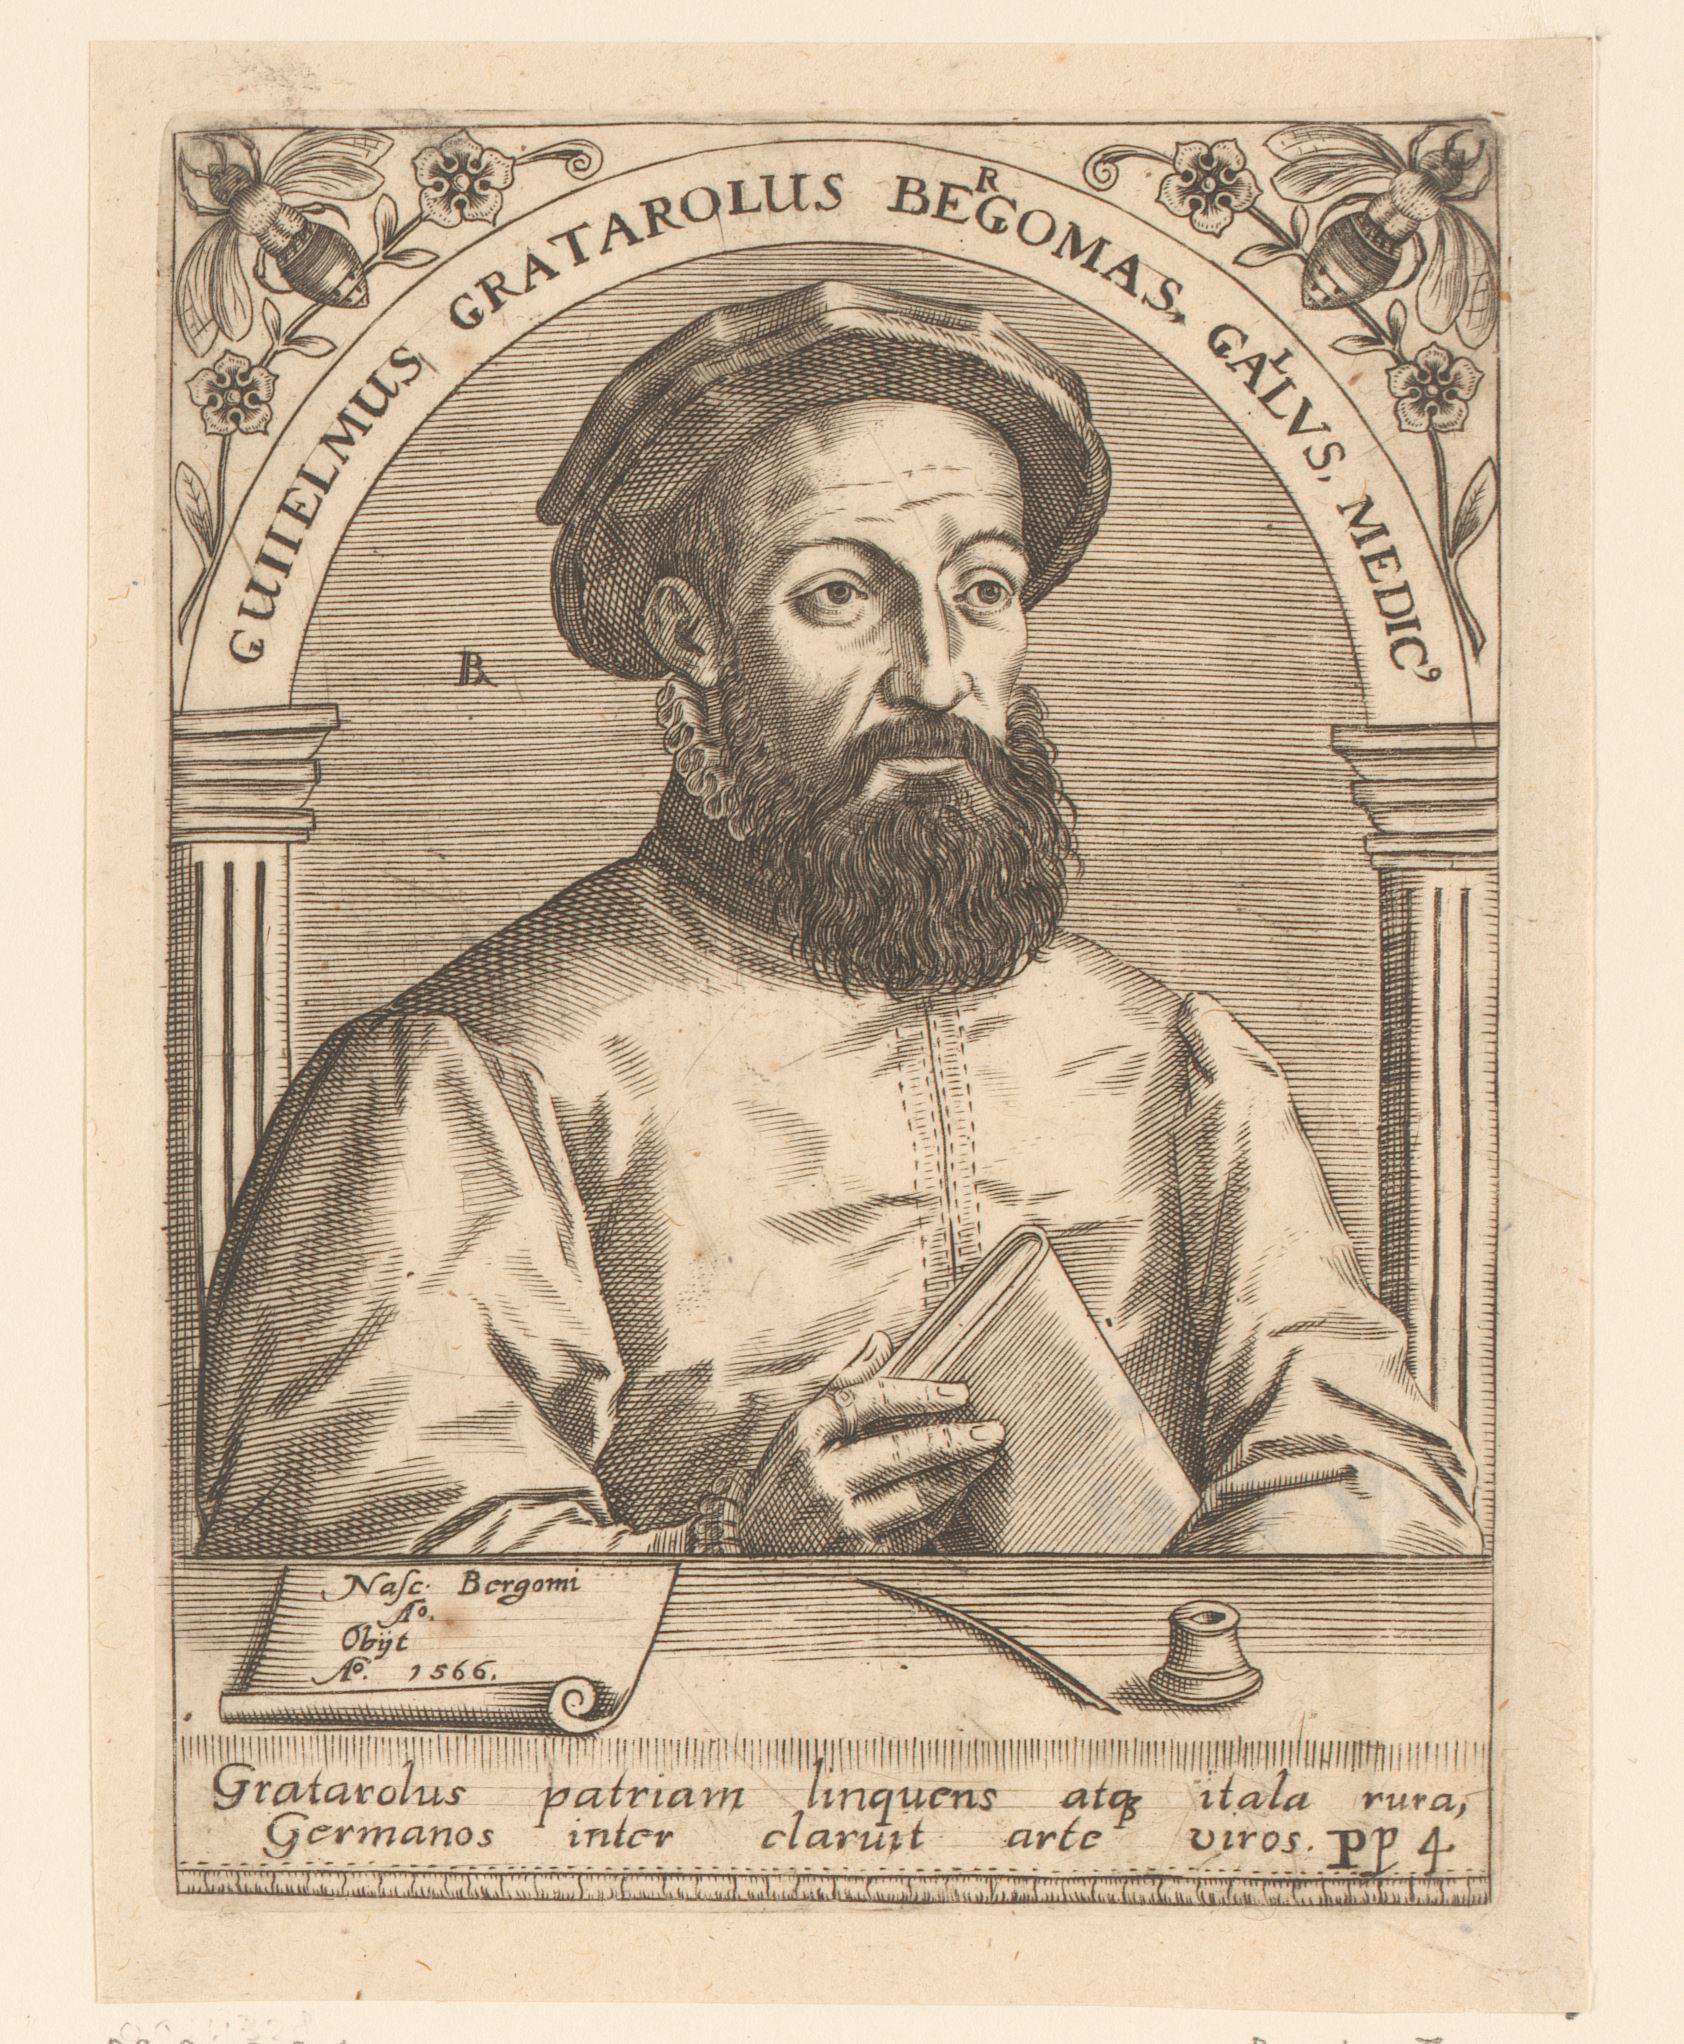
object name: print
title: Serie portretten van vijftiende- en zestiende-eeuwse geleerden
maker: robert boissard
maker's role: print maker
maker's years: 1570-1611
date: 1597-1599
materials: paper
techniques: engraving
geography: france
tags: flowers, ink-well, historical persons, book, insects: bee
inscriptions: collector's mark: Lugt 2228